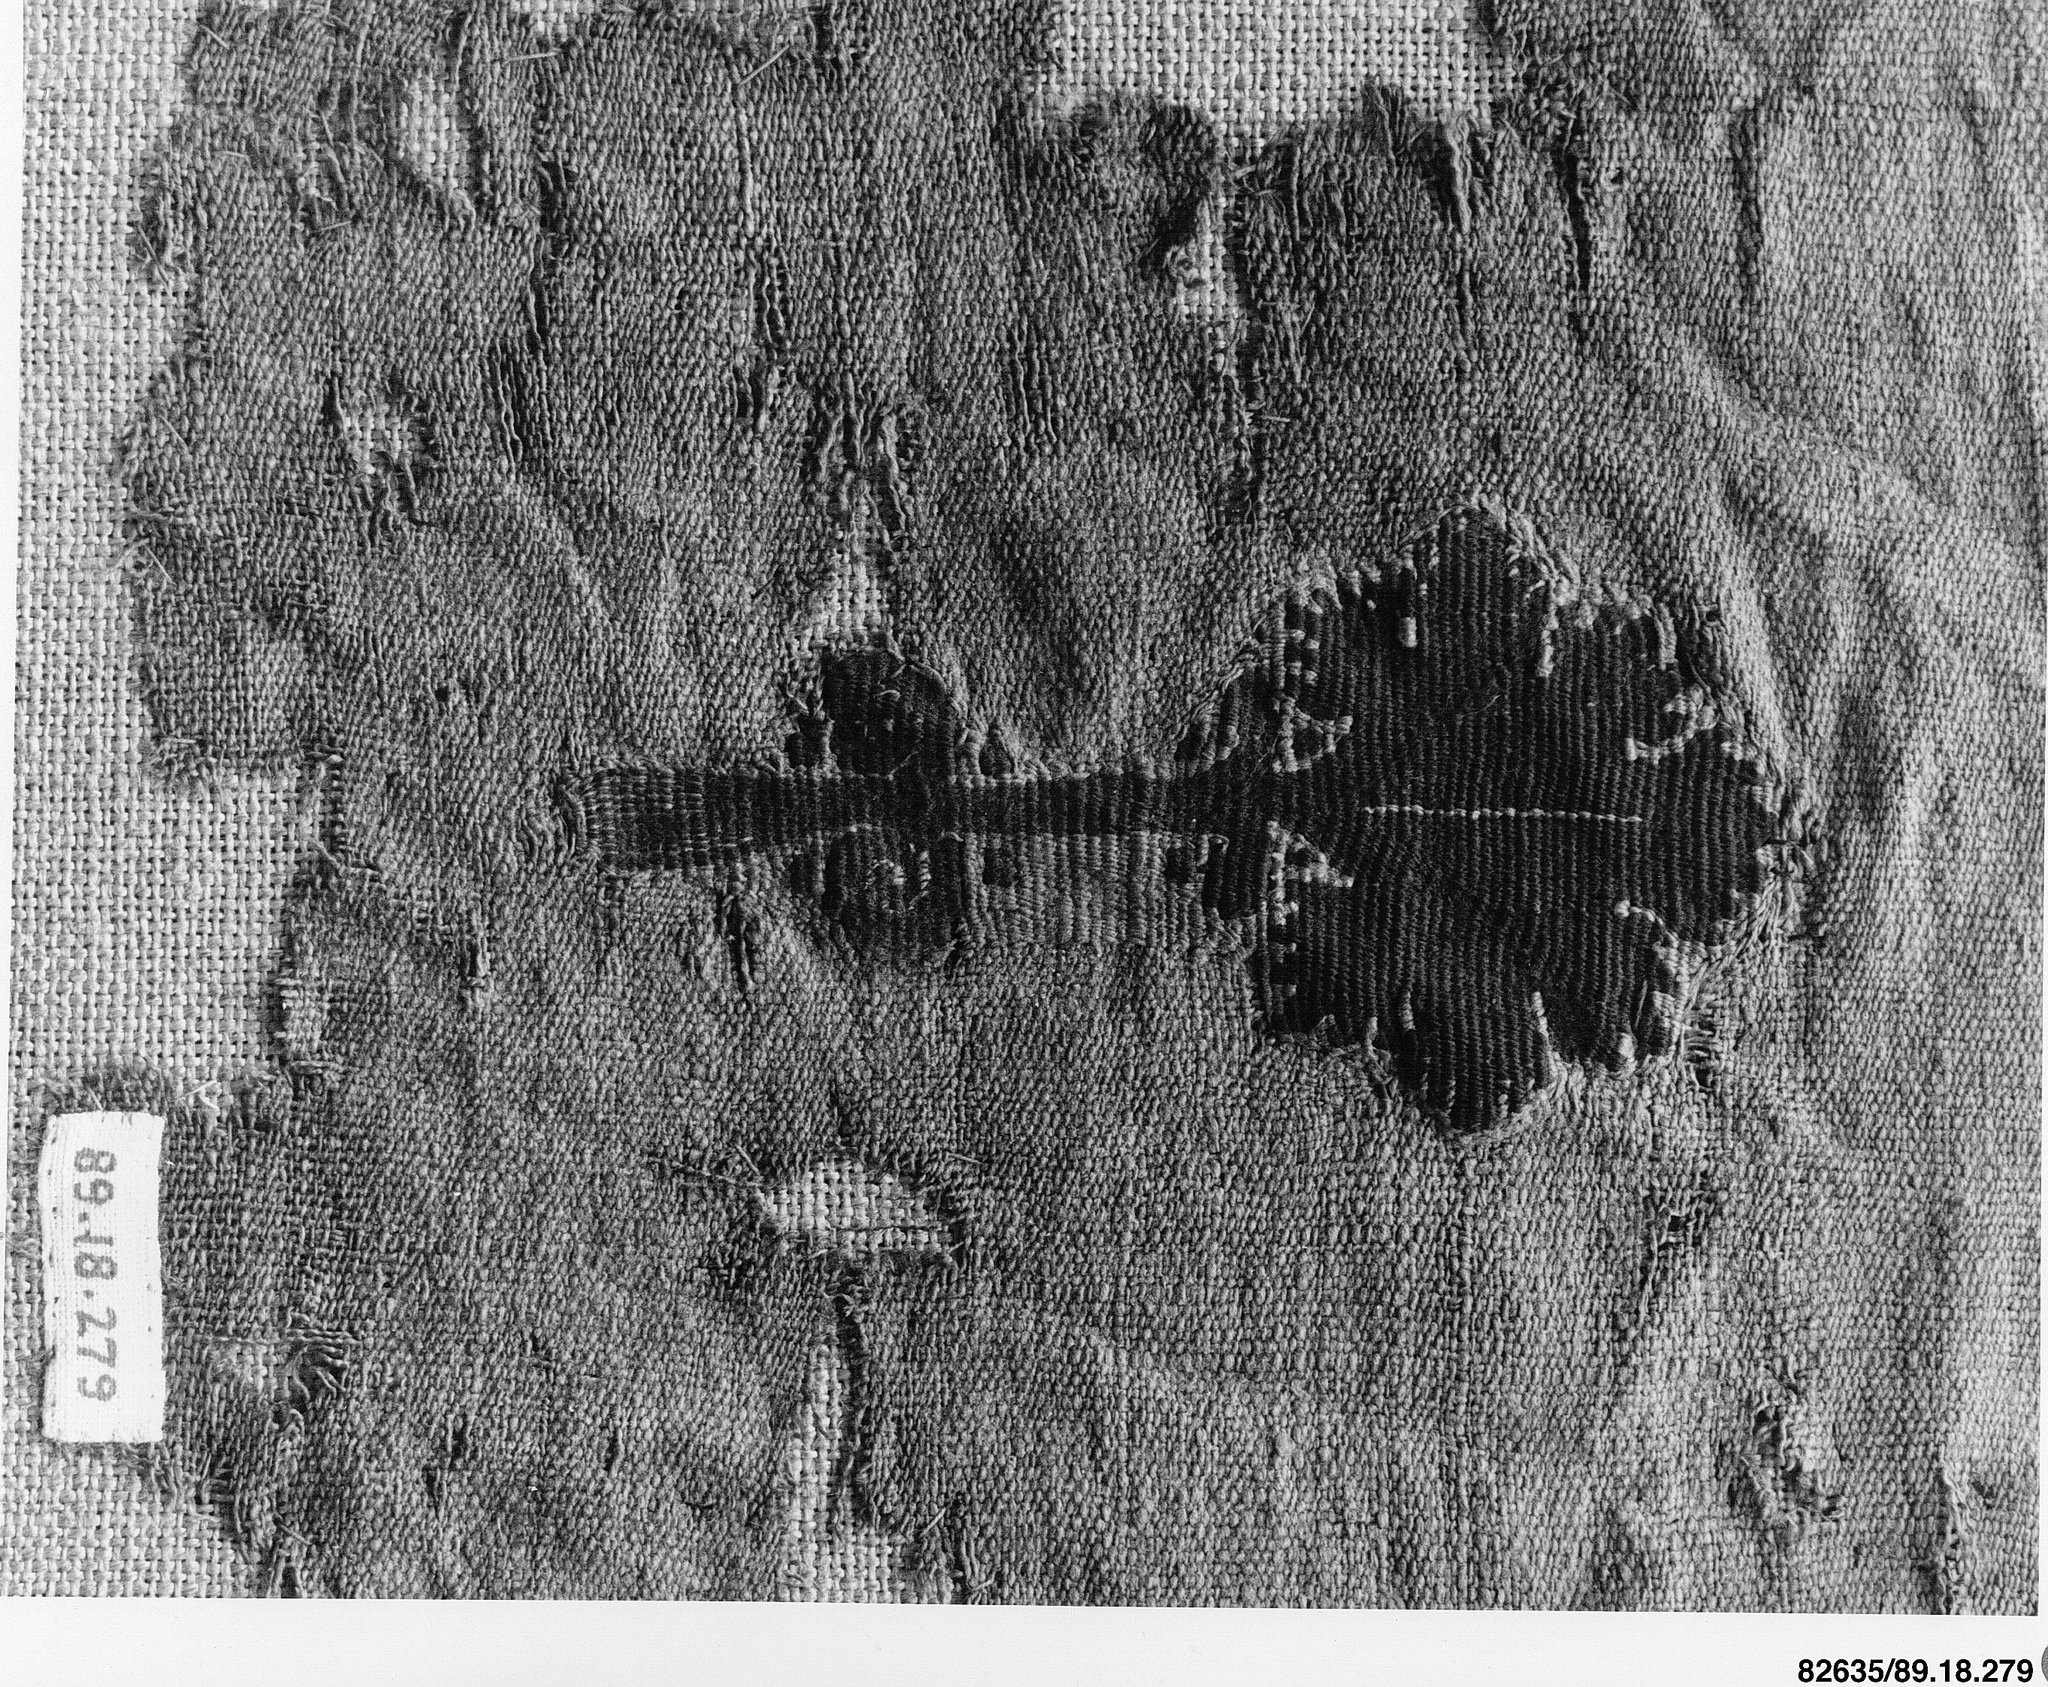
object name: textile fragment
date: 301-400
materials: linen, wool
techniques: weave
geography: egypt